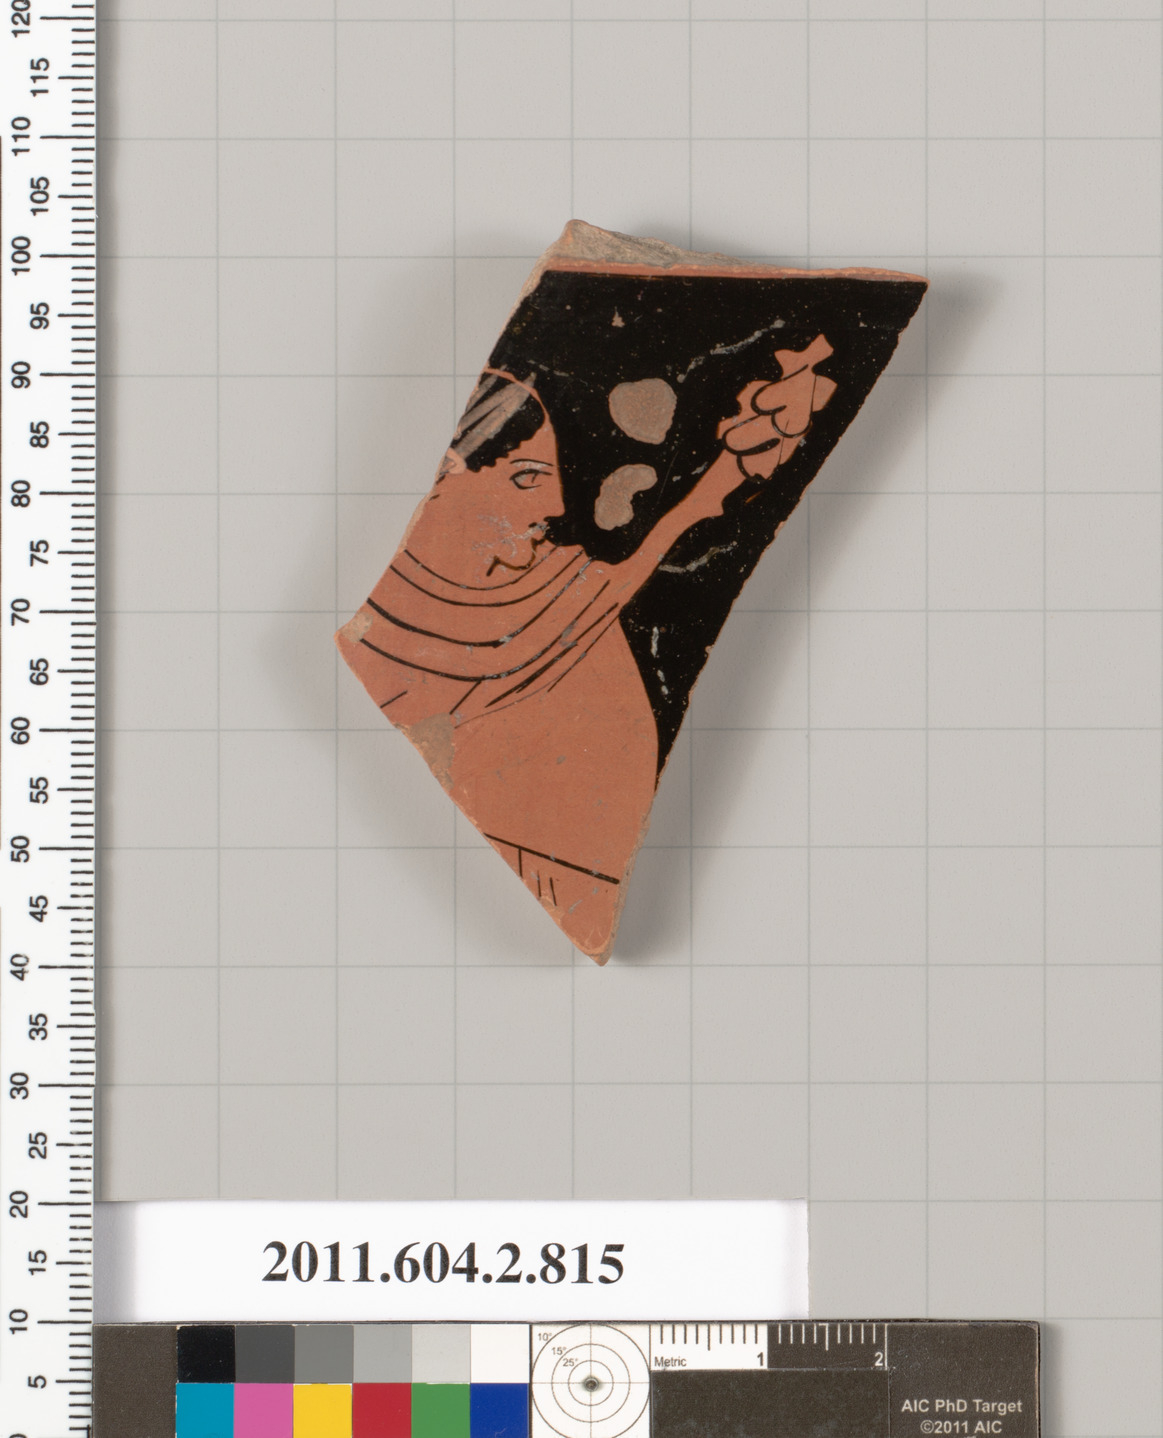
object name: bell krater fragment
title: Terracotta fragment of a bell-krater (bowl for mixing wine and water)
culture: greek, attic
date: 450-426 BCE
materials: terracotta